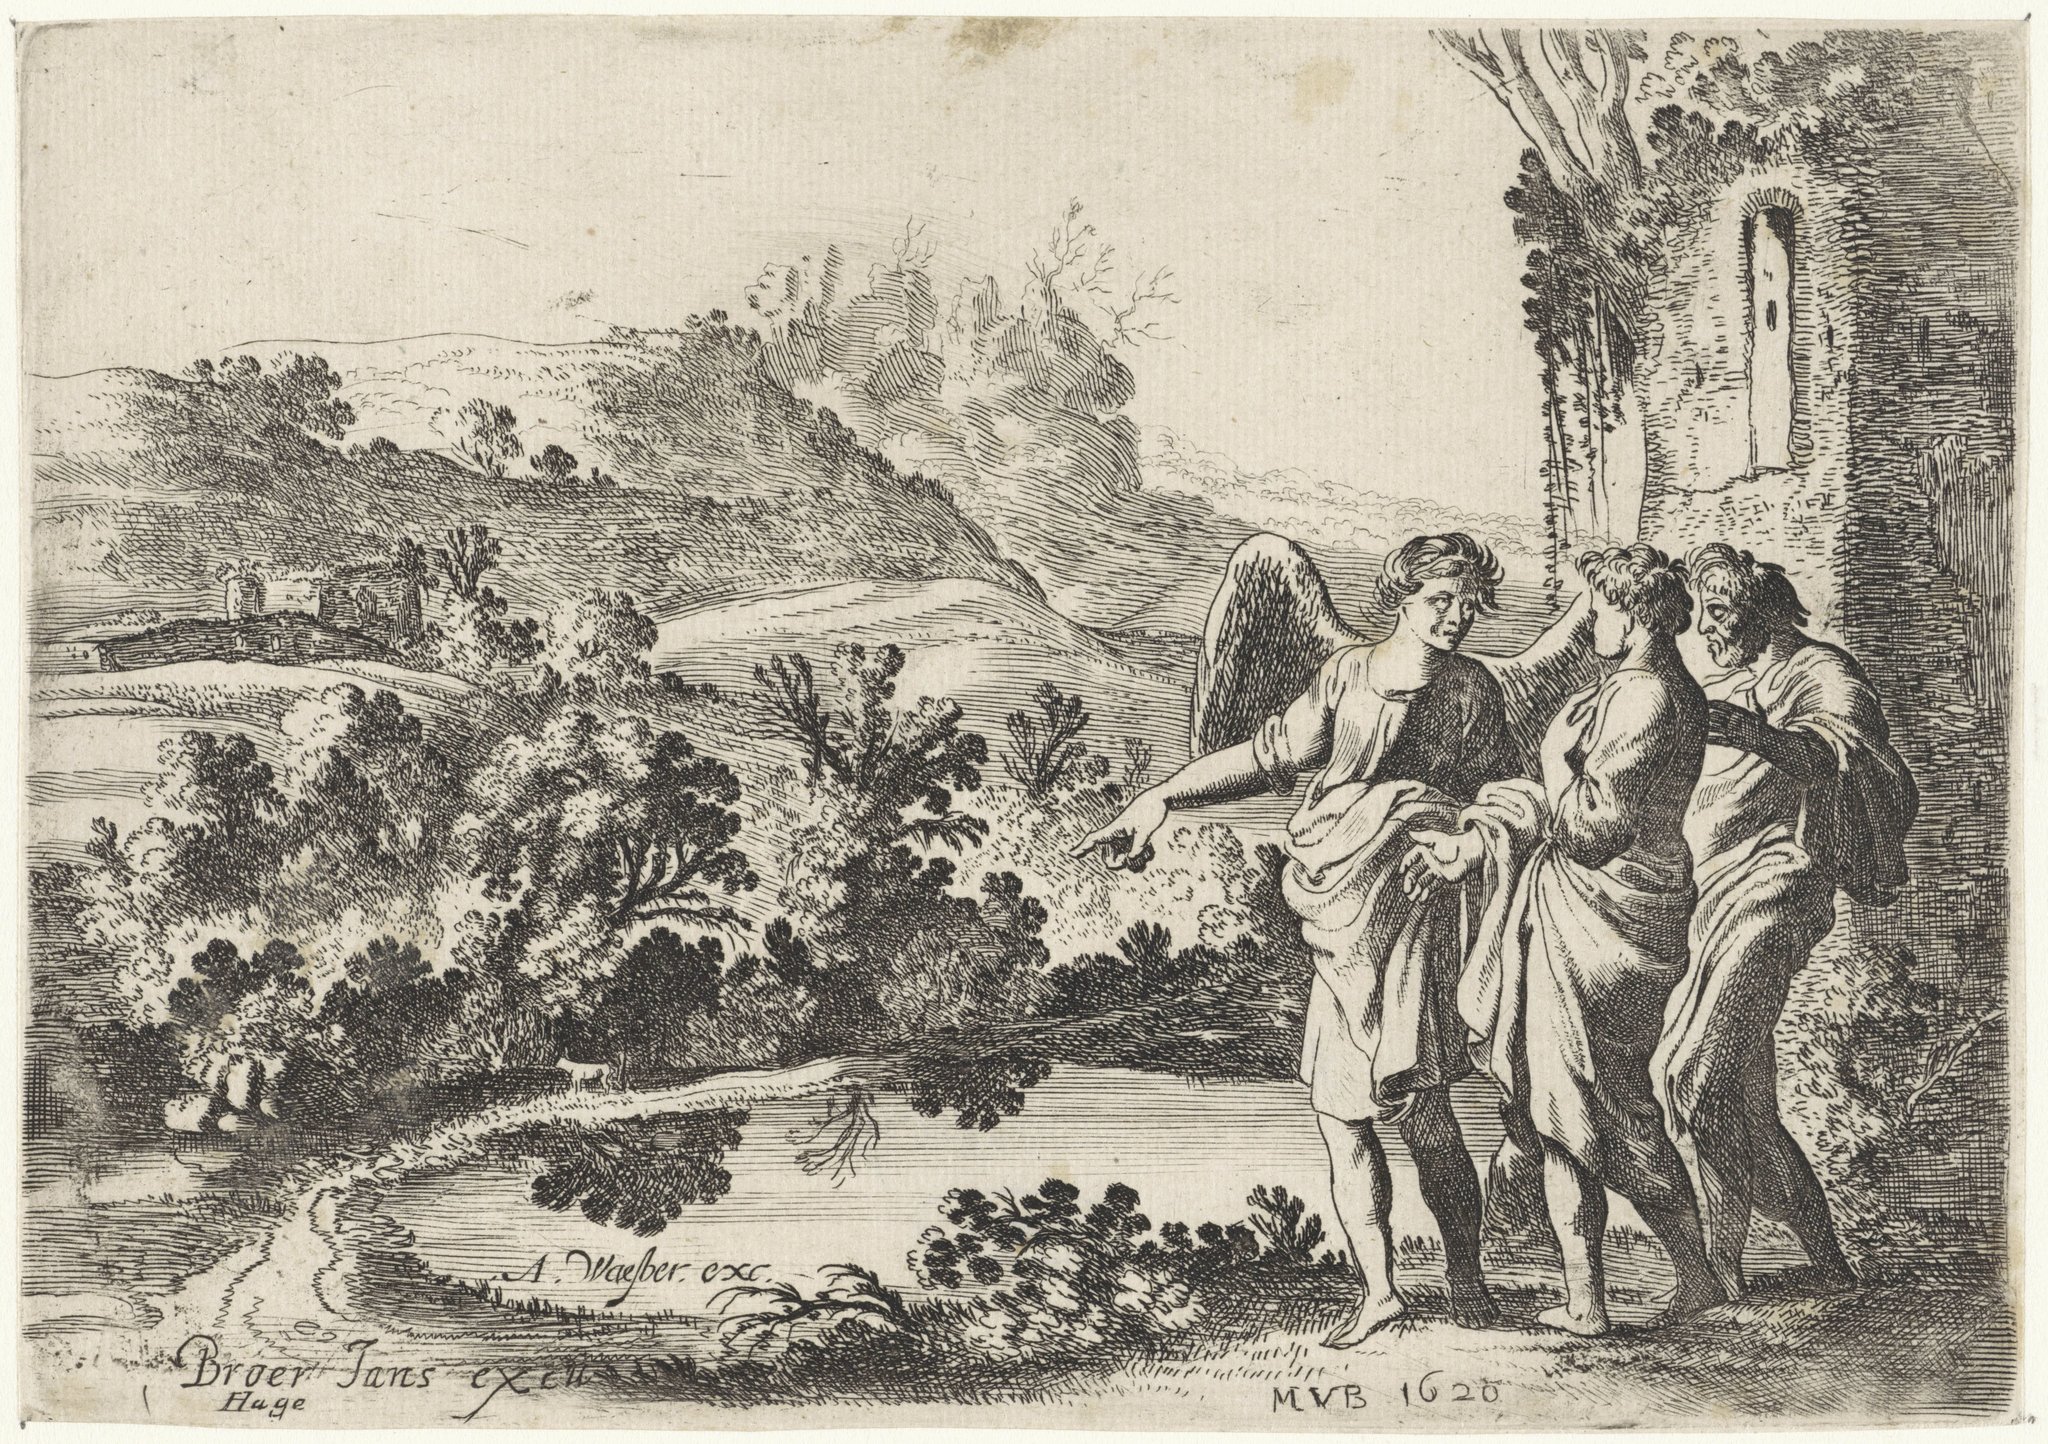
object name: print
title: Het verhaal van Tobias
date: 1620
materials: paper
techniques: etching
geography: the hague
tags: tobias and the angel raphael with tobit (and anna)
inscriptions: collector's mark: Lugt 2228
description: In een heuvellandschap staat Tobit die zijn zoon Tobias aan de engel toe vertrouwt. Genummerd als I.